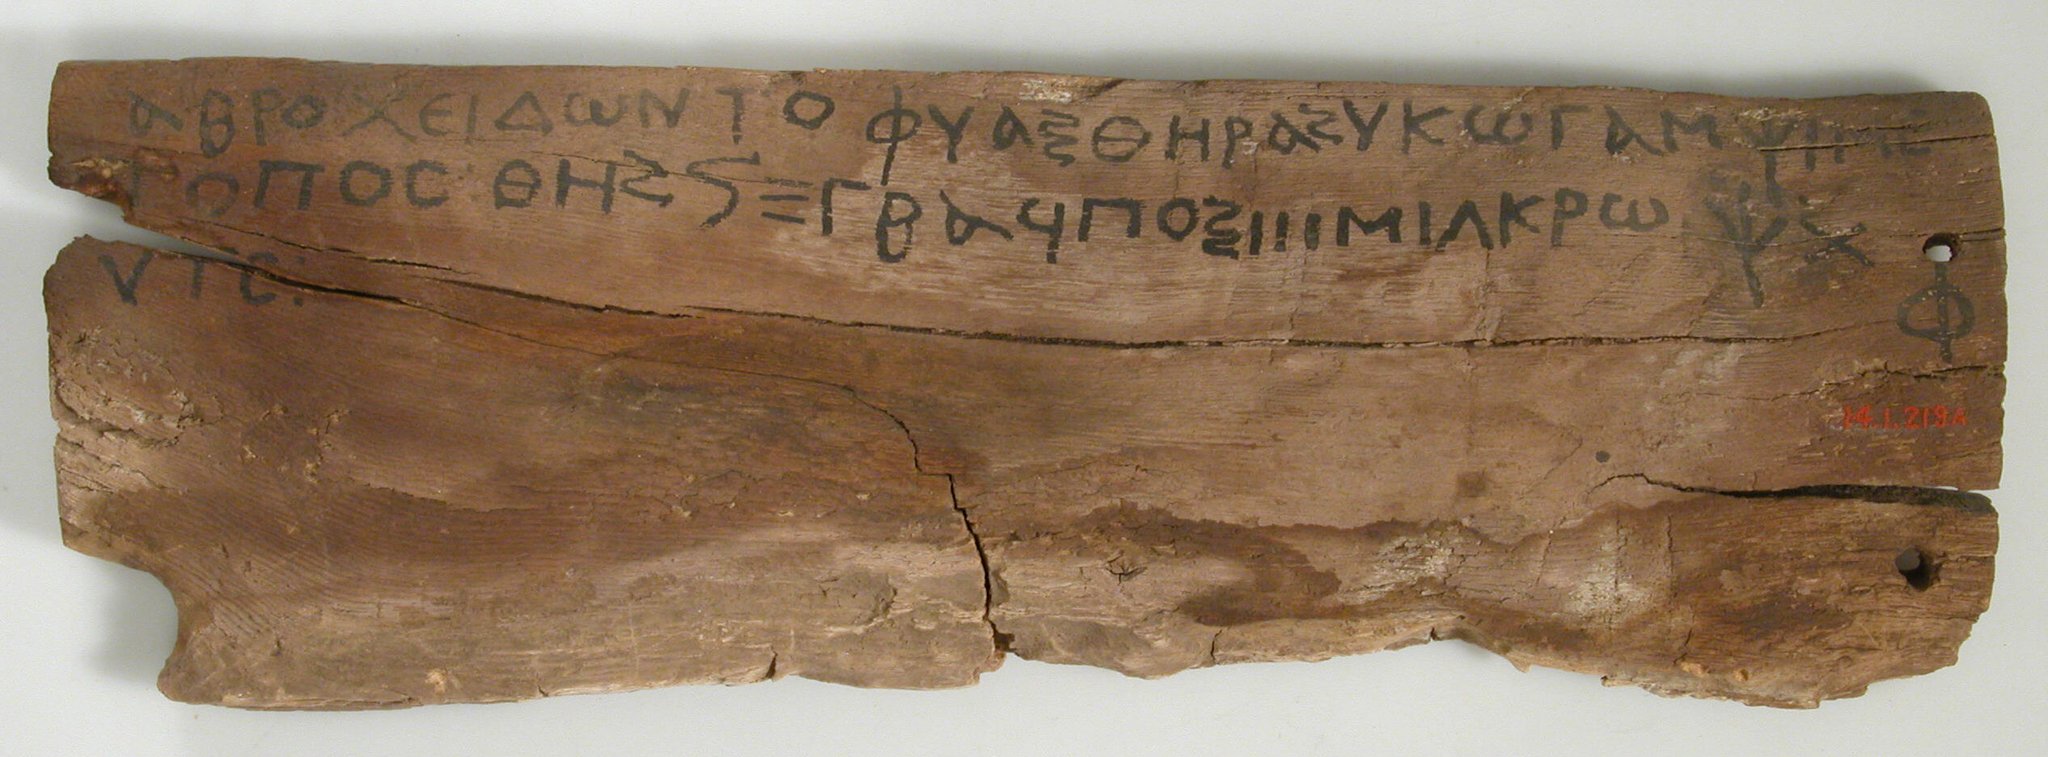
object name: ostrakon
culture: coptic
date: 580-640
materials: ink, wood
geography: egypt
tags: greek